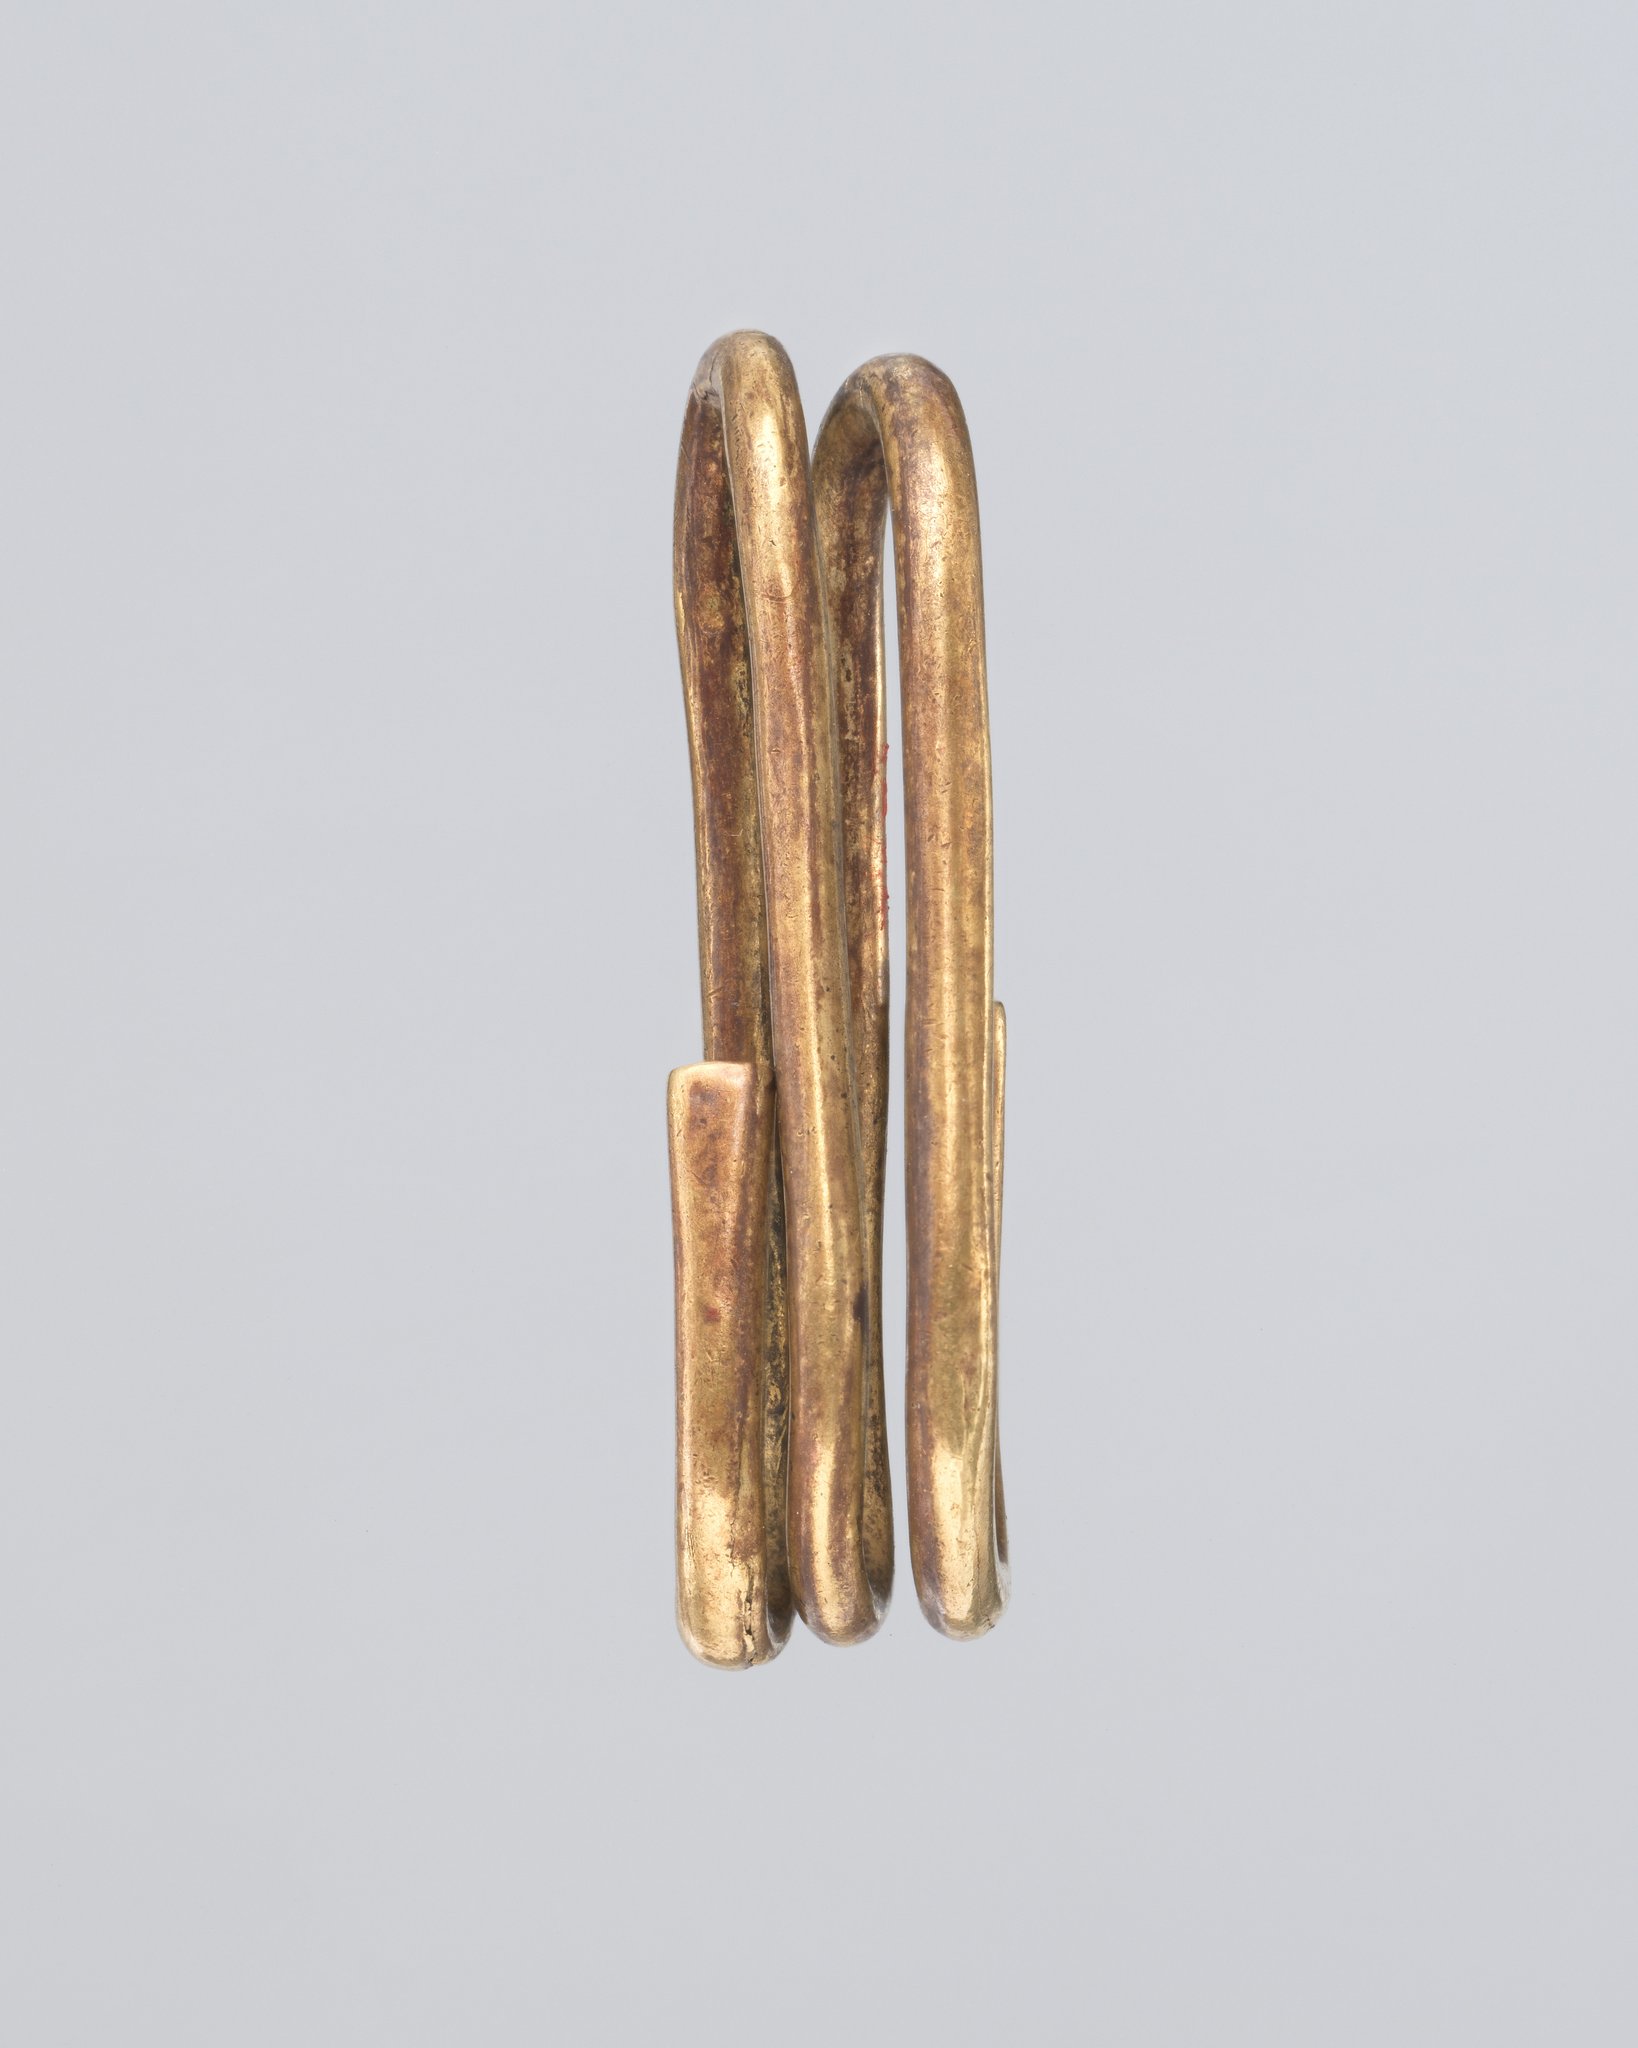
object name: earring or spiral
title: Gold spiral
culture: cypriot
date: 1600-1100 BCE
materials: gold